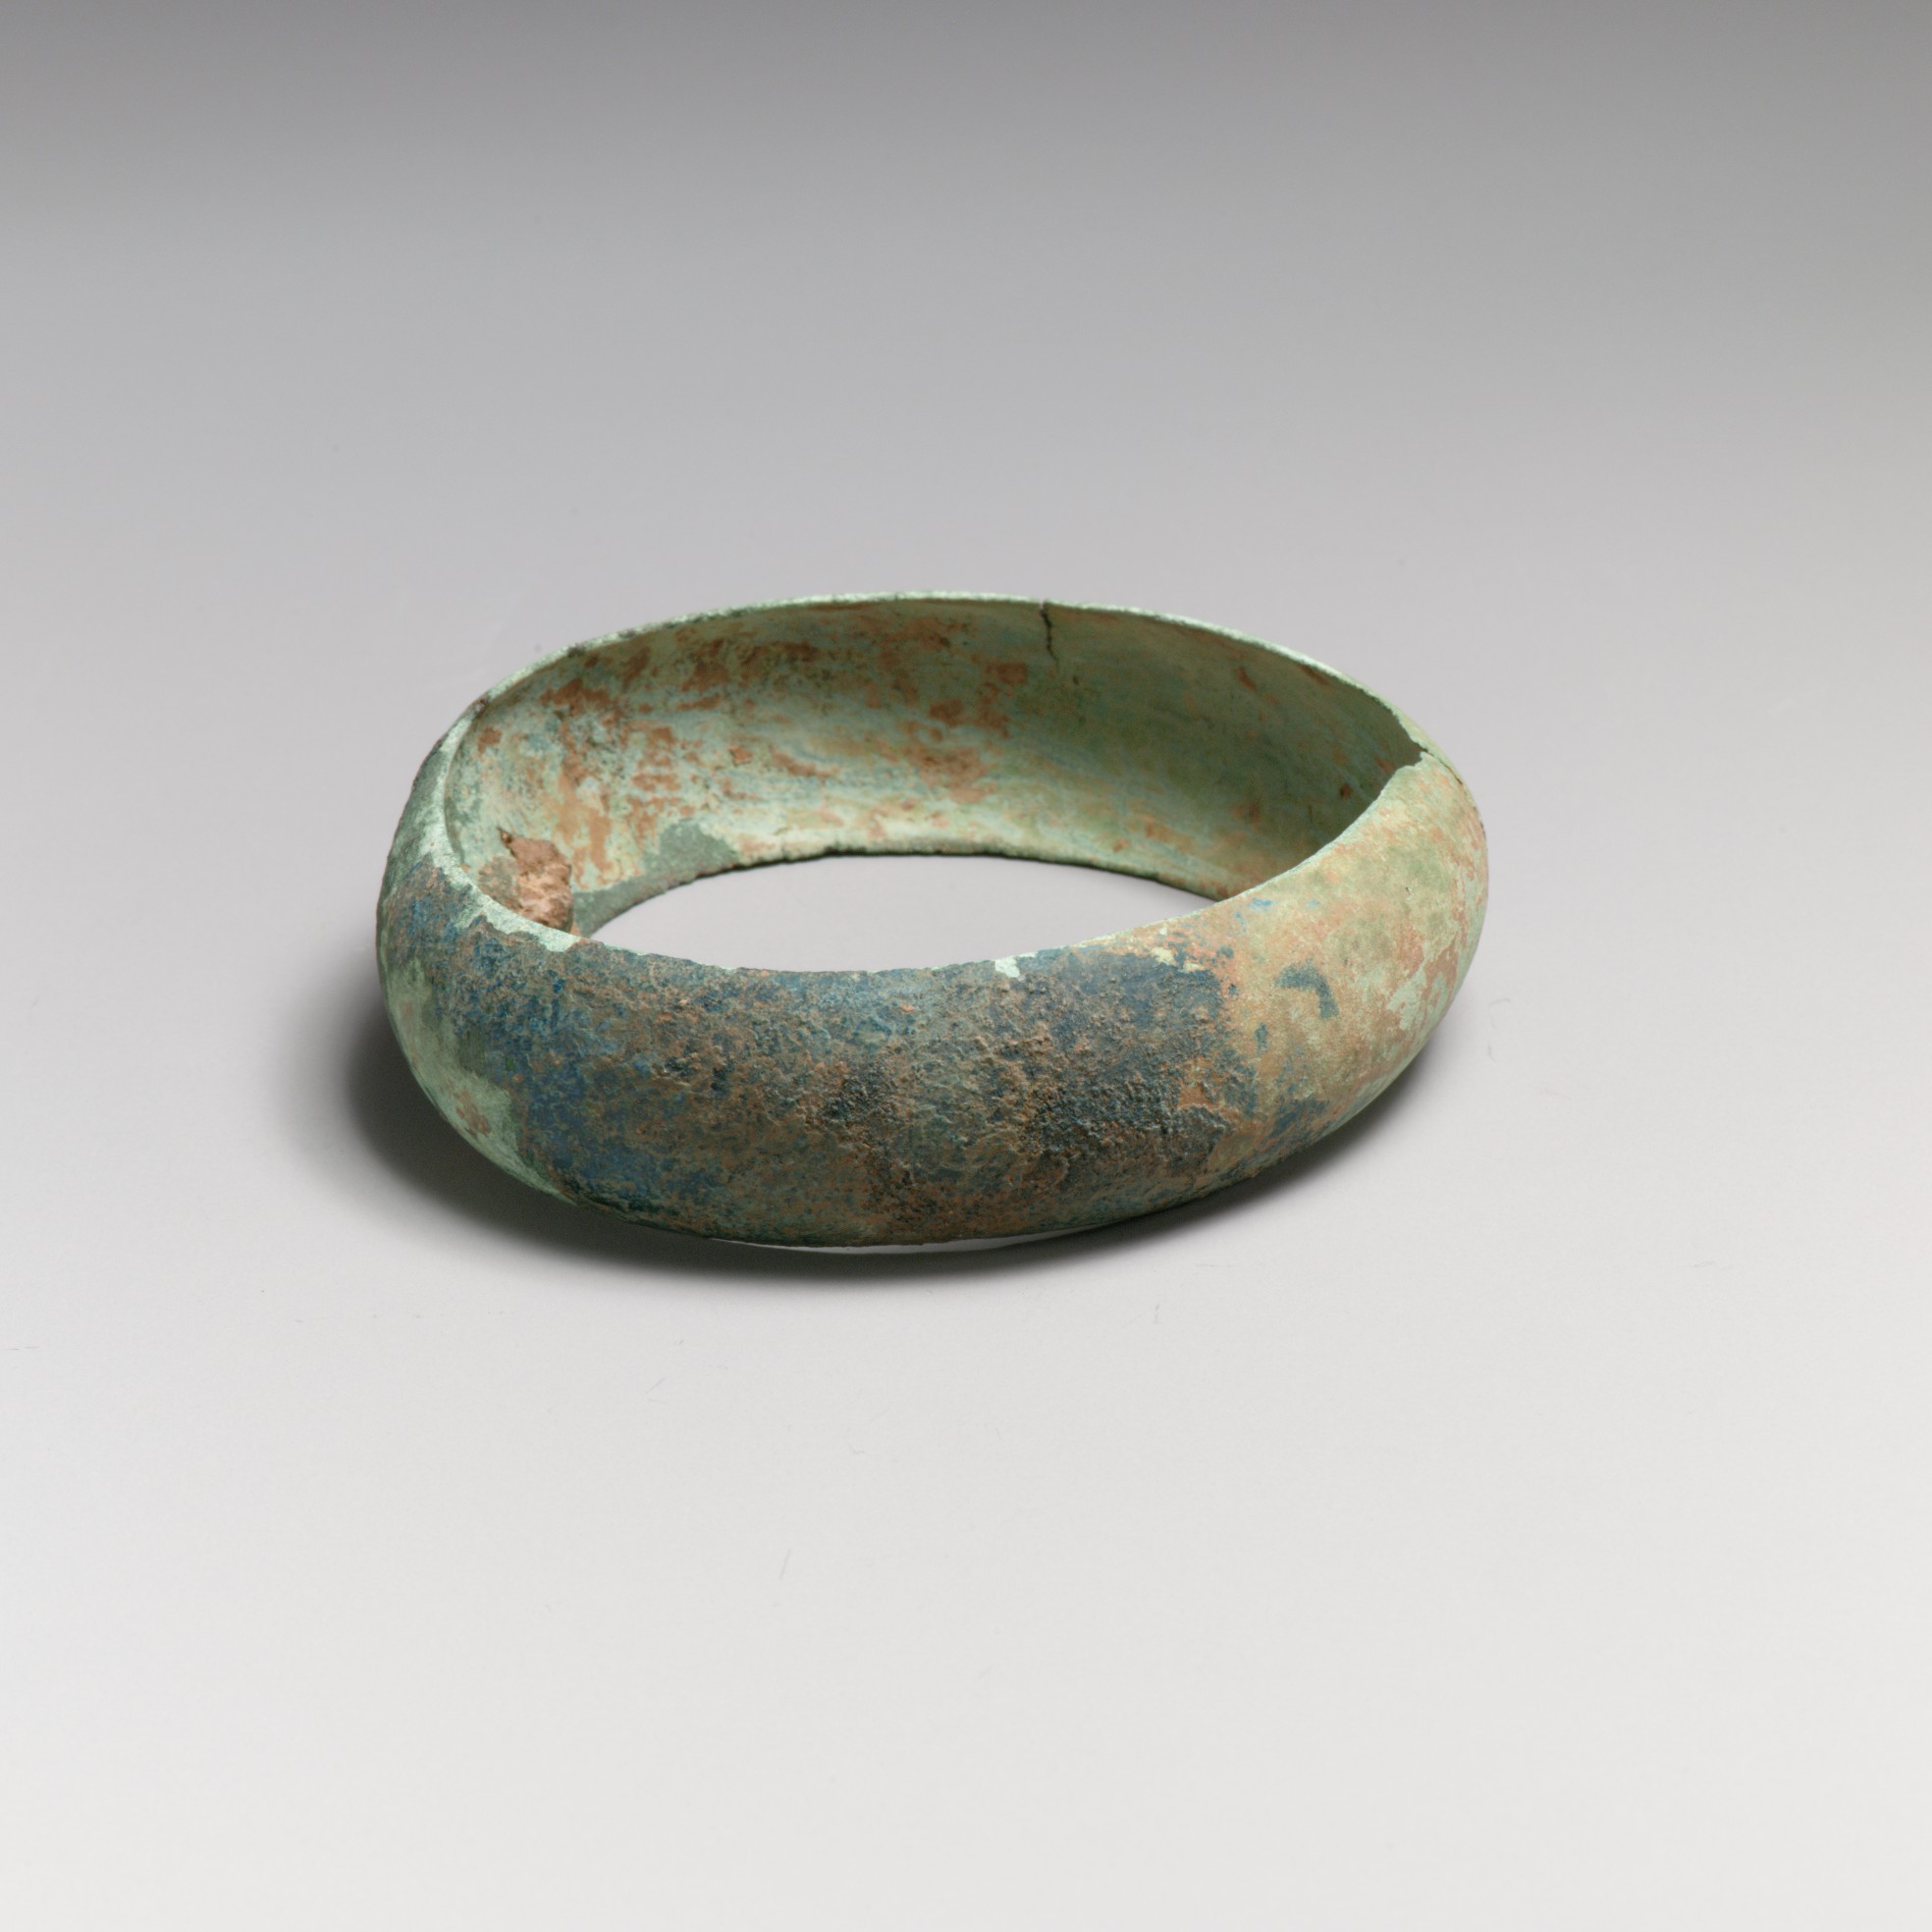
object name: bracelet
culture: italic, villanovan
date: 900-701 BCE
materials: bronze